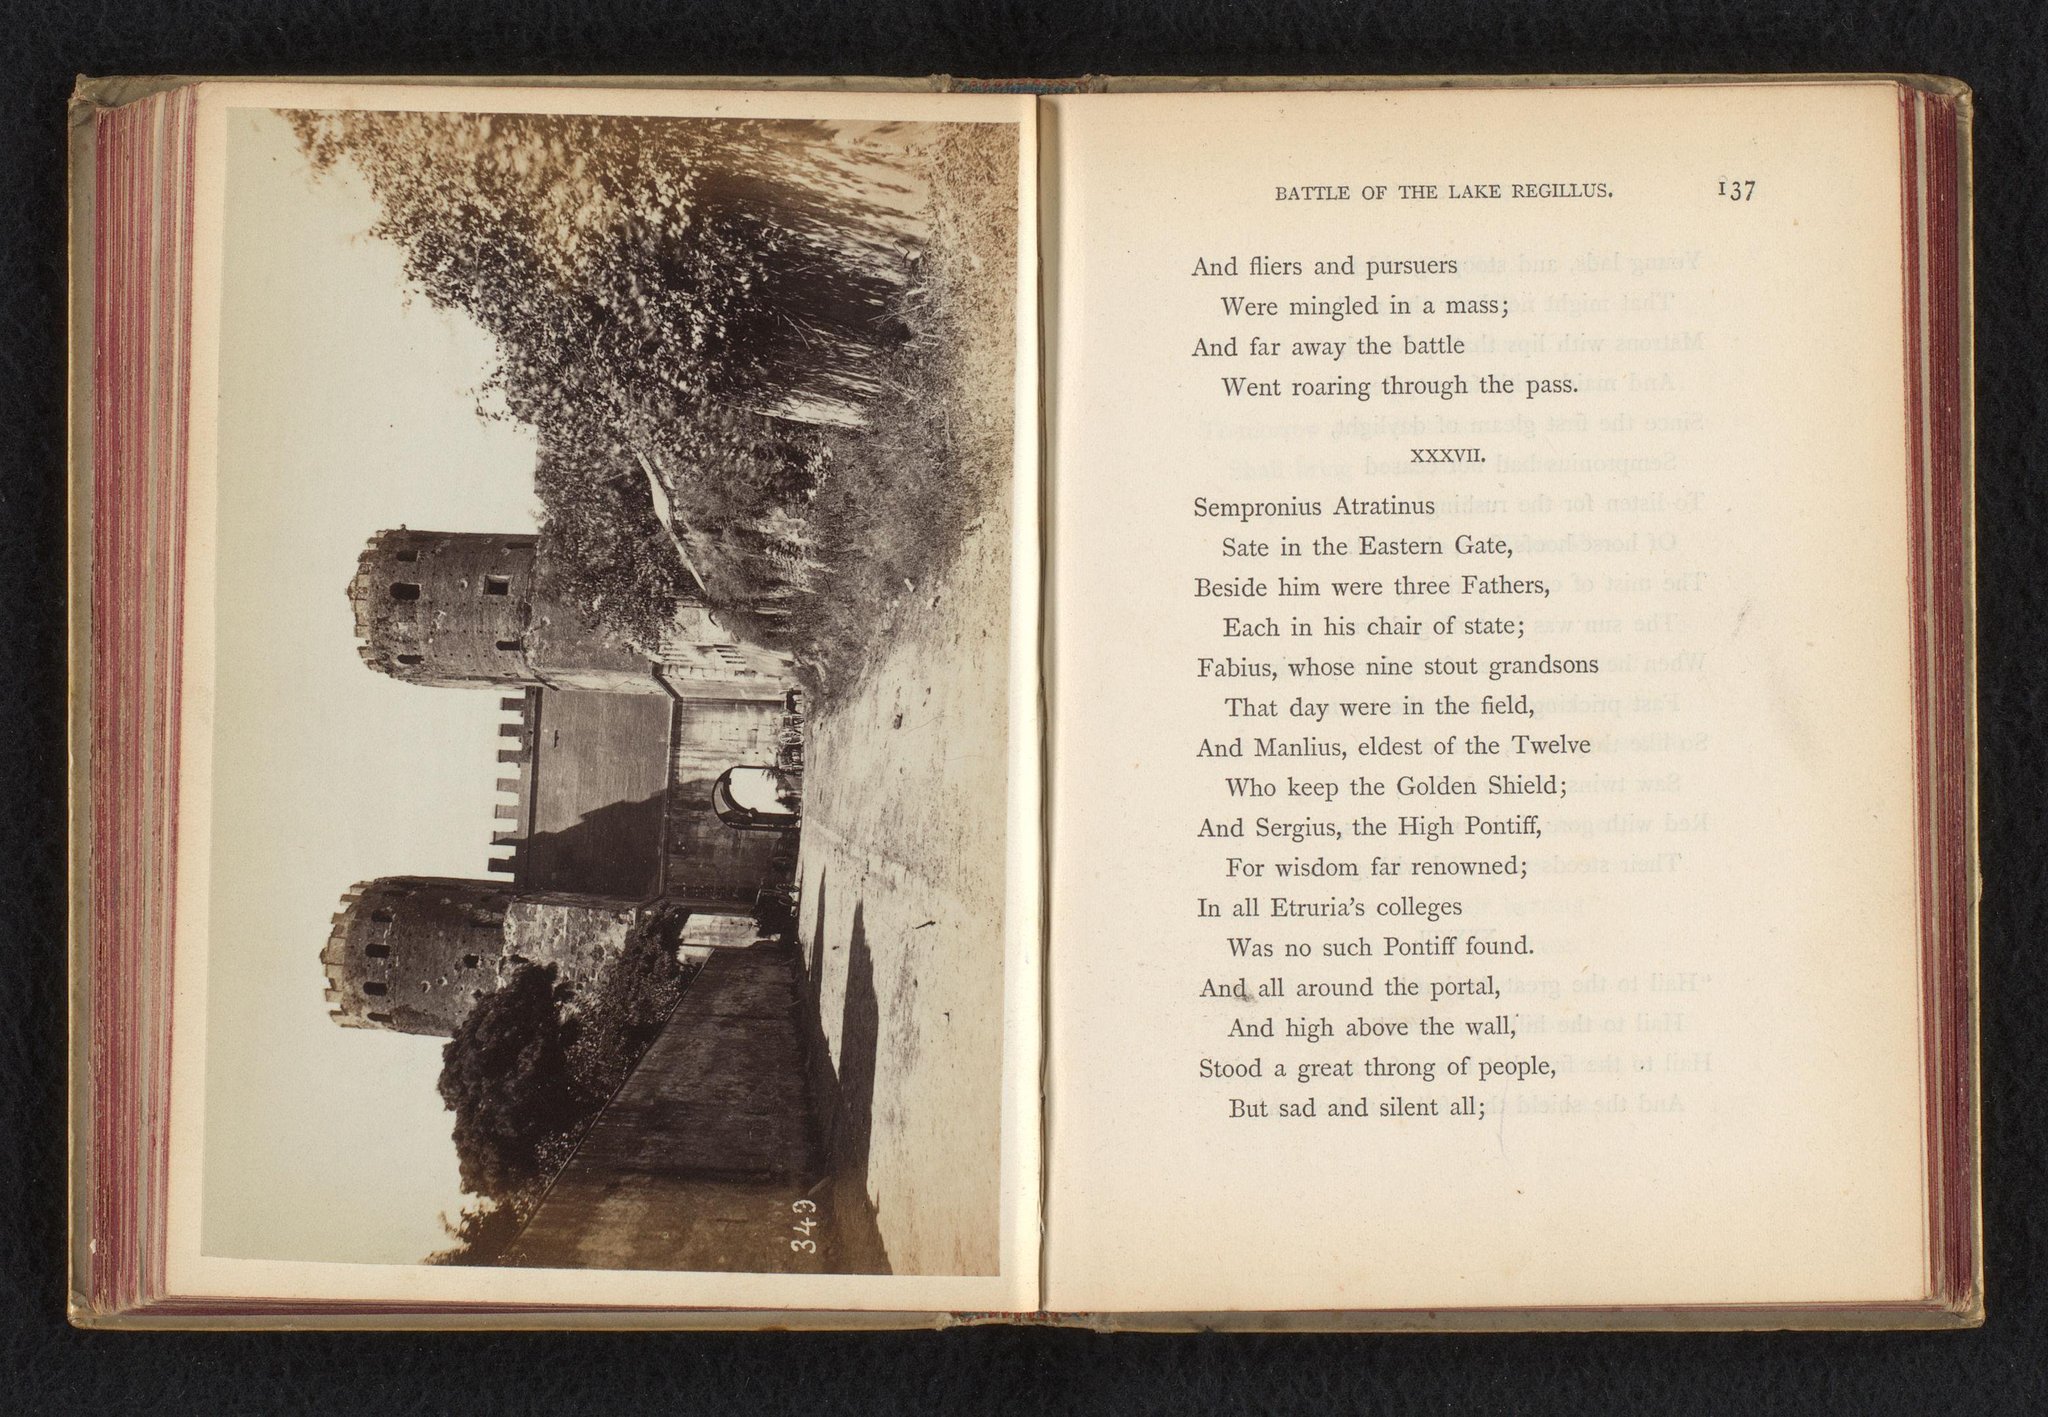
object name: page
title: Porta San Sebastiano en de Via Appia, Rome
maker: Anonymous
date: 1851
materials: paper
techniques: albumen print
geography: rome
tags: city-gate, public road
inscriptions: number: ‘349’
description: Foto op ongenummerde pagina tegenover pagina 137.